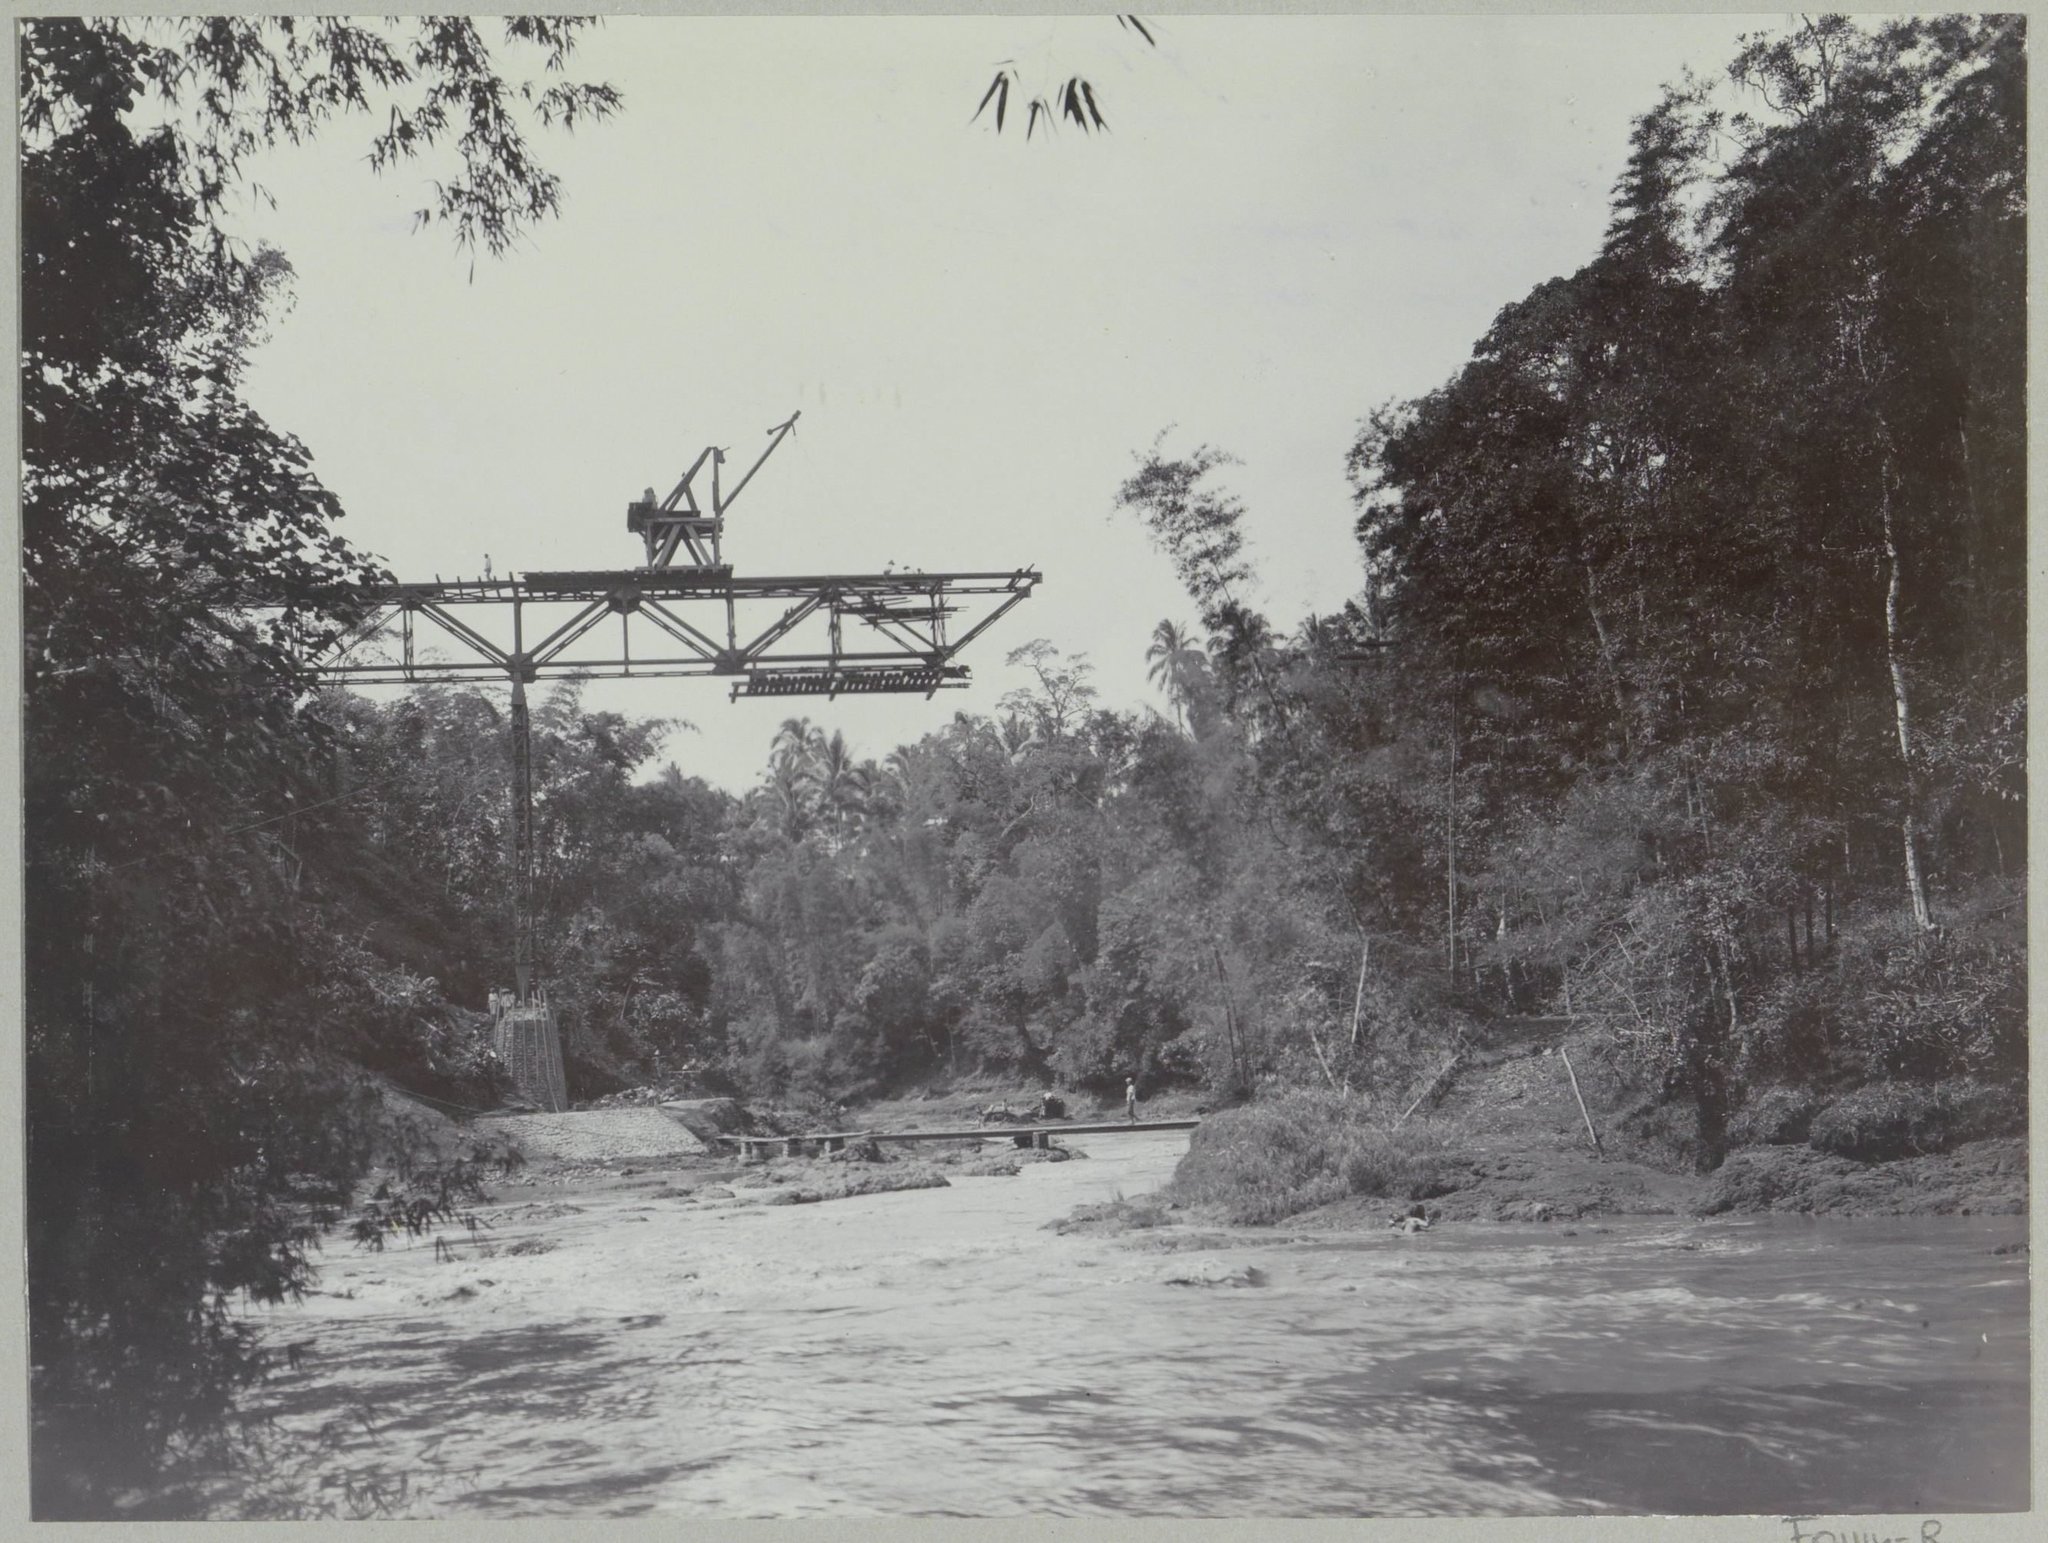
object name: photograph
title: Bouw van het middenstuk van een brug over de Kali Brantas ten zuiden van Malang (Photo XVIII)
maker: Anonymous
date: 1890-1920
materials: cardboard, paper, photographic support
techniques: gelatin silver print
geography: java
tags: engineering, landscape with bridge, viaduct or aqueduct, bridge, building-site, java, dutch east indies, the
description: Foto met op de linkerpagina het bijbehorende bijschrift. Onderdeel van Fotoalbum met opnames van de bouw van een brug over de Kali Brantas ten zuiden van Malang op Java.